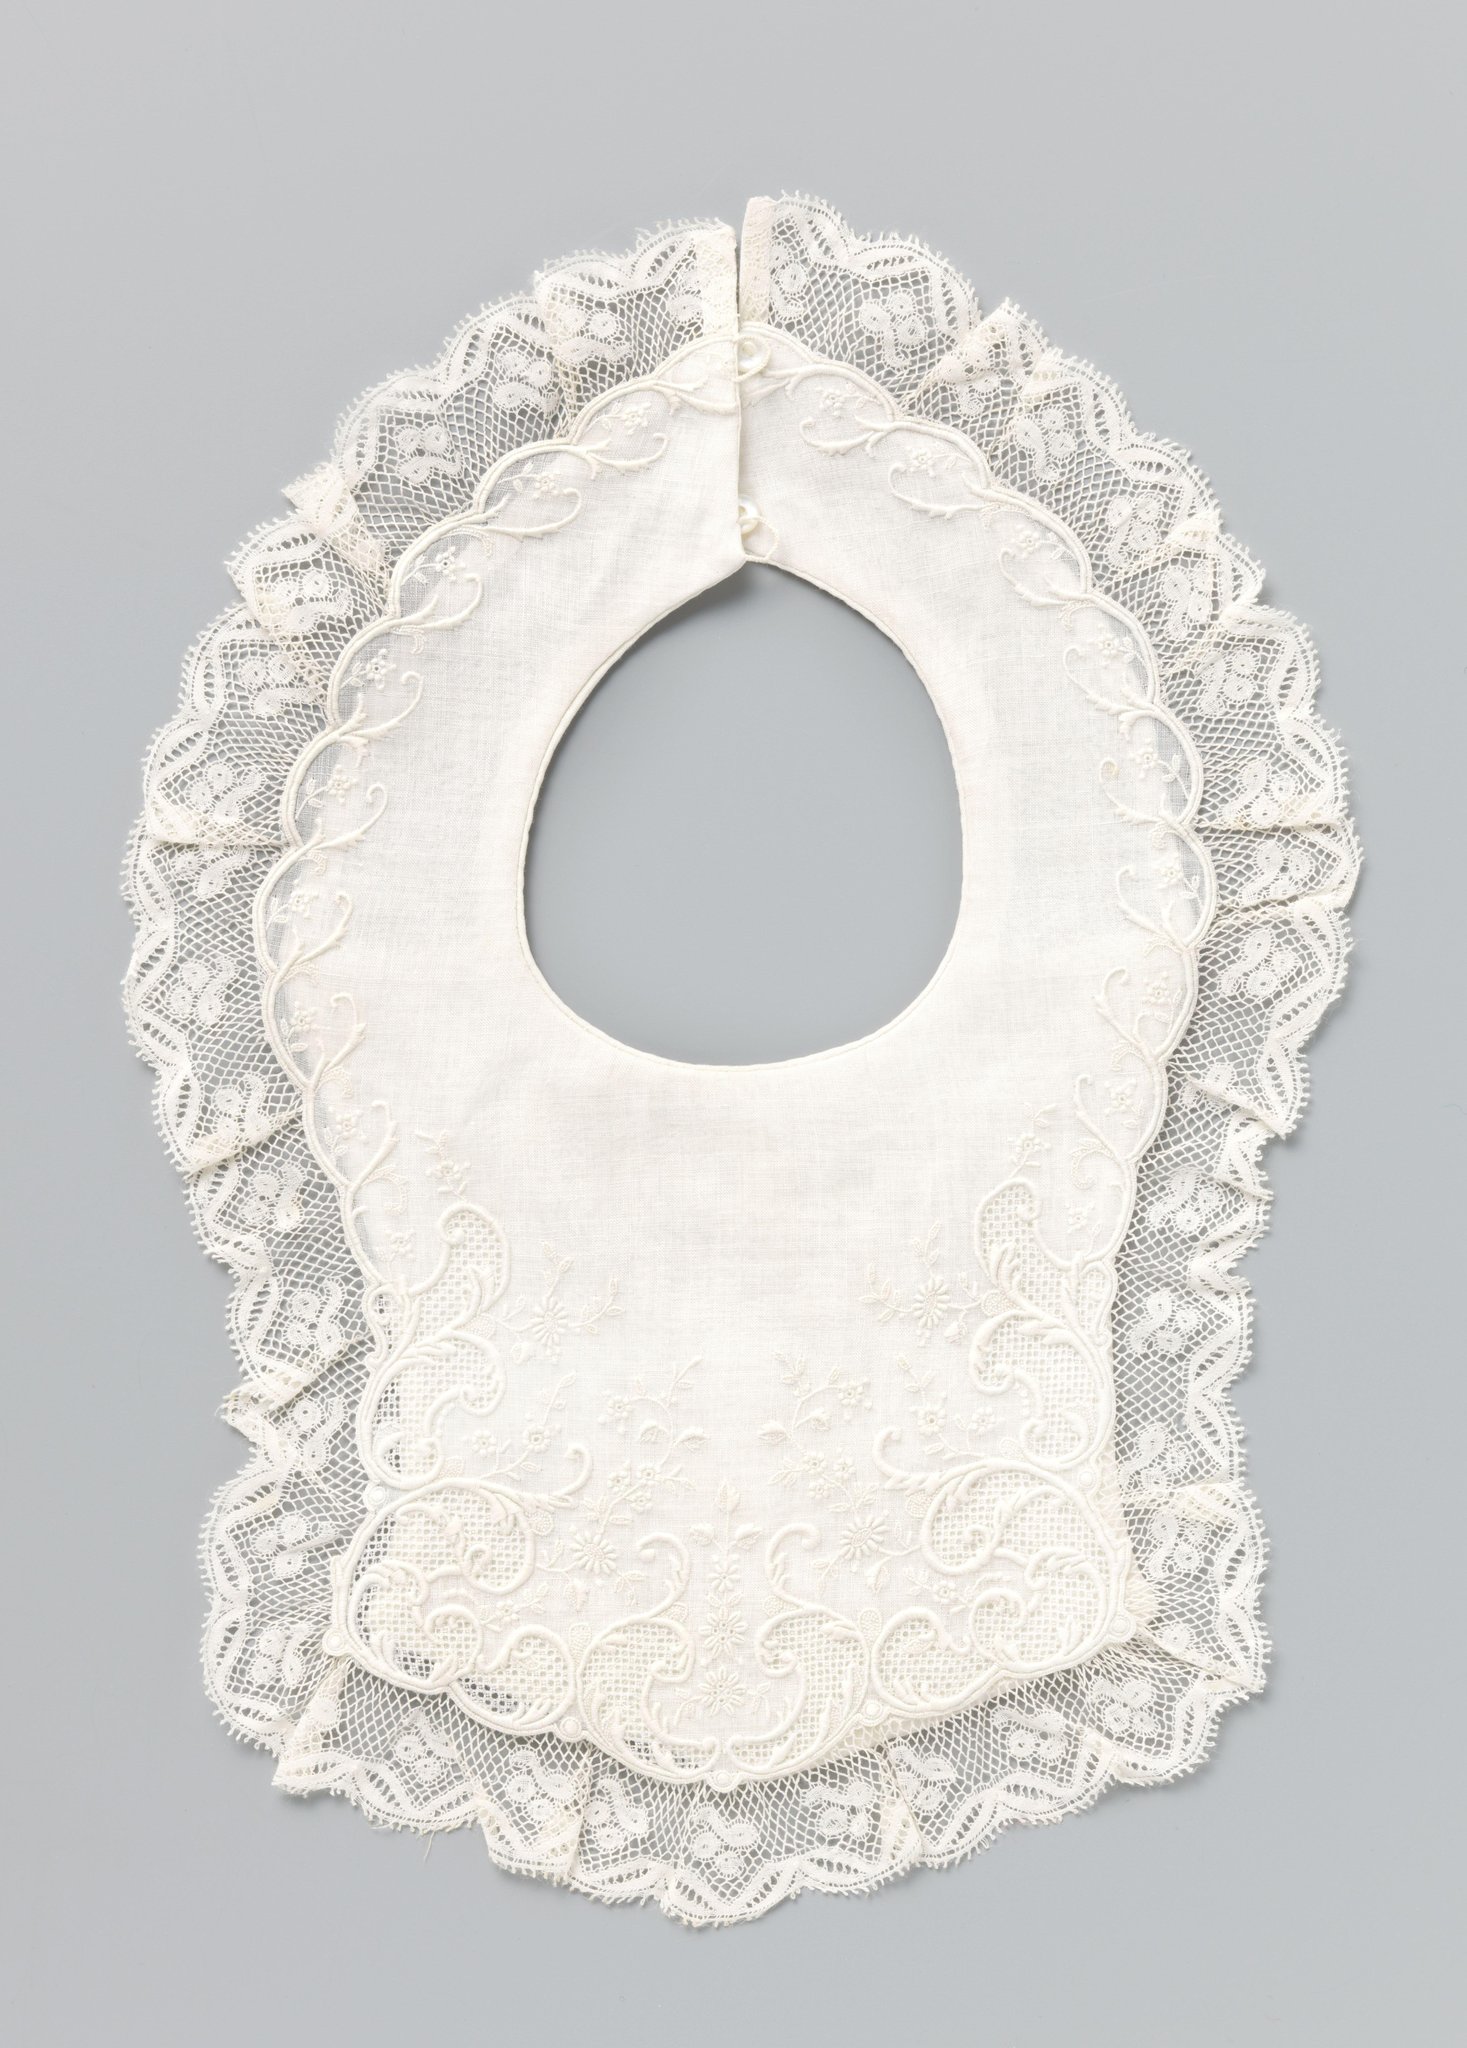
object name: bib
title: Slab van wit batist, versierd met matelassé-werk en Valenciennes-kant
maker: Anonymous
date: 1905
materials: textile, mother of pearl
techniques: matelassé, quilting, lace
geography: western europe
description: Slab van batist, versierd met matelassé-werk in de vorm van voluten en bloemranken. De randen zijn afgezet met een strook Valenciennes-kant. De slab kan worden gesloten door middel van 2 knopen aan de achterzijde.